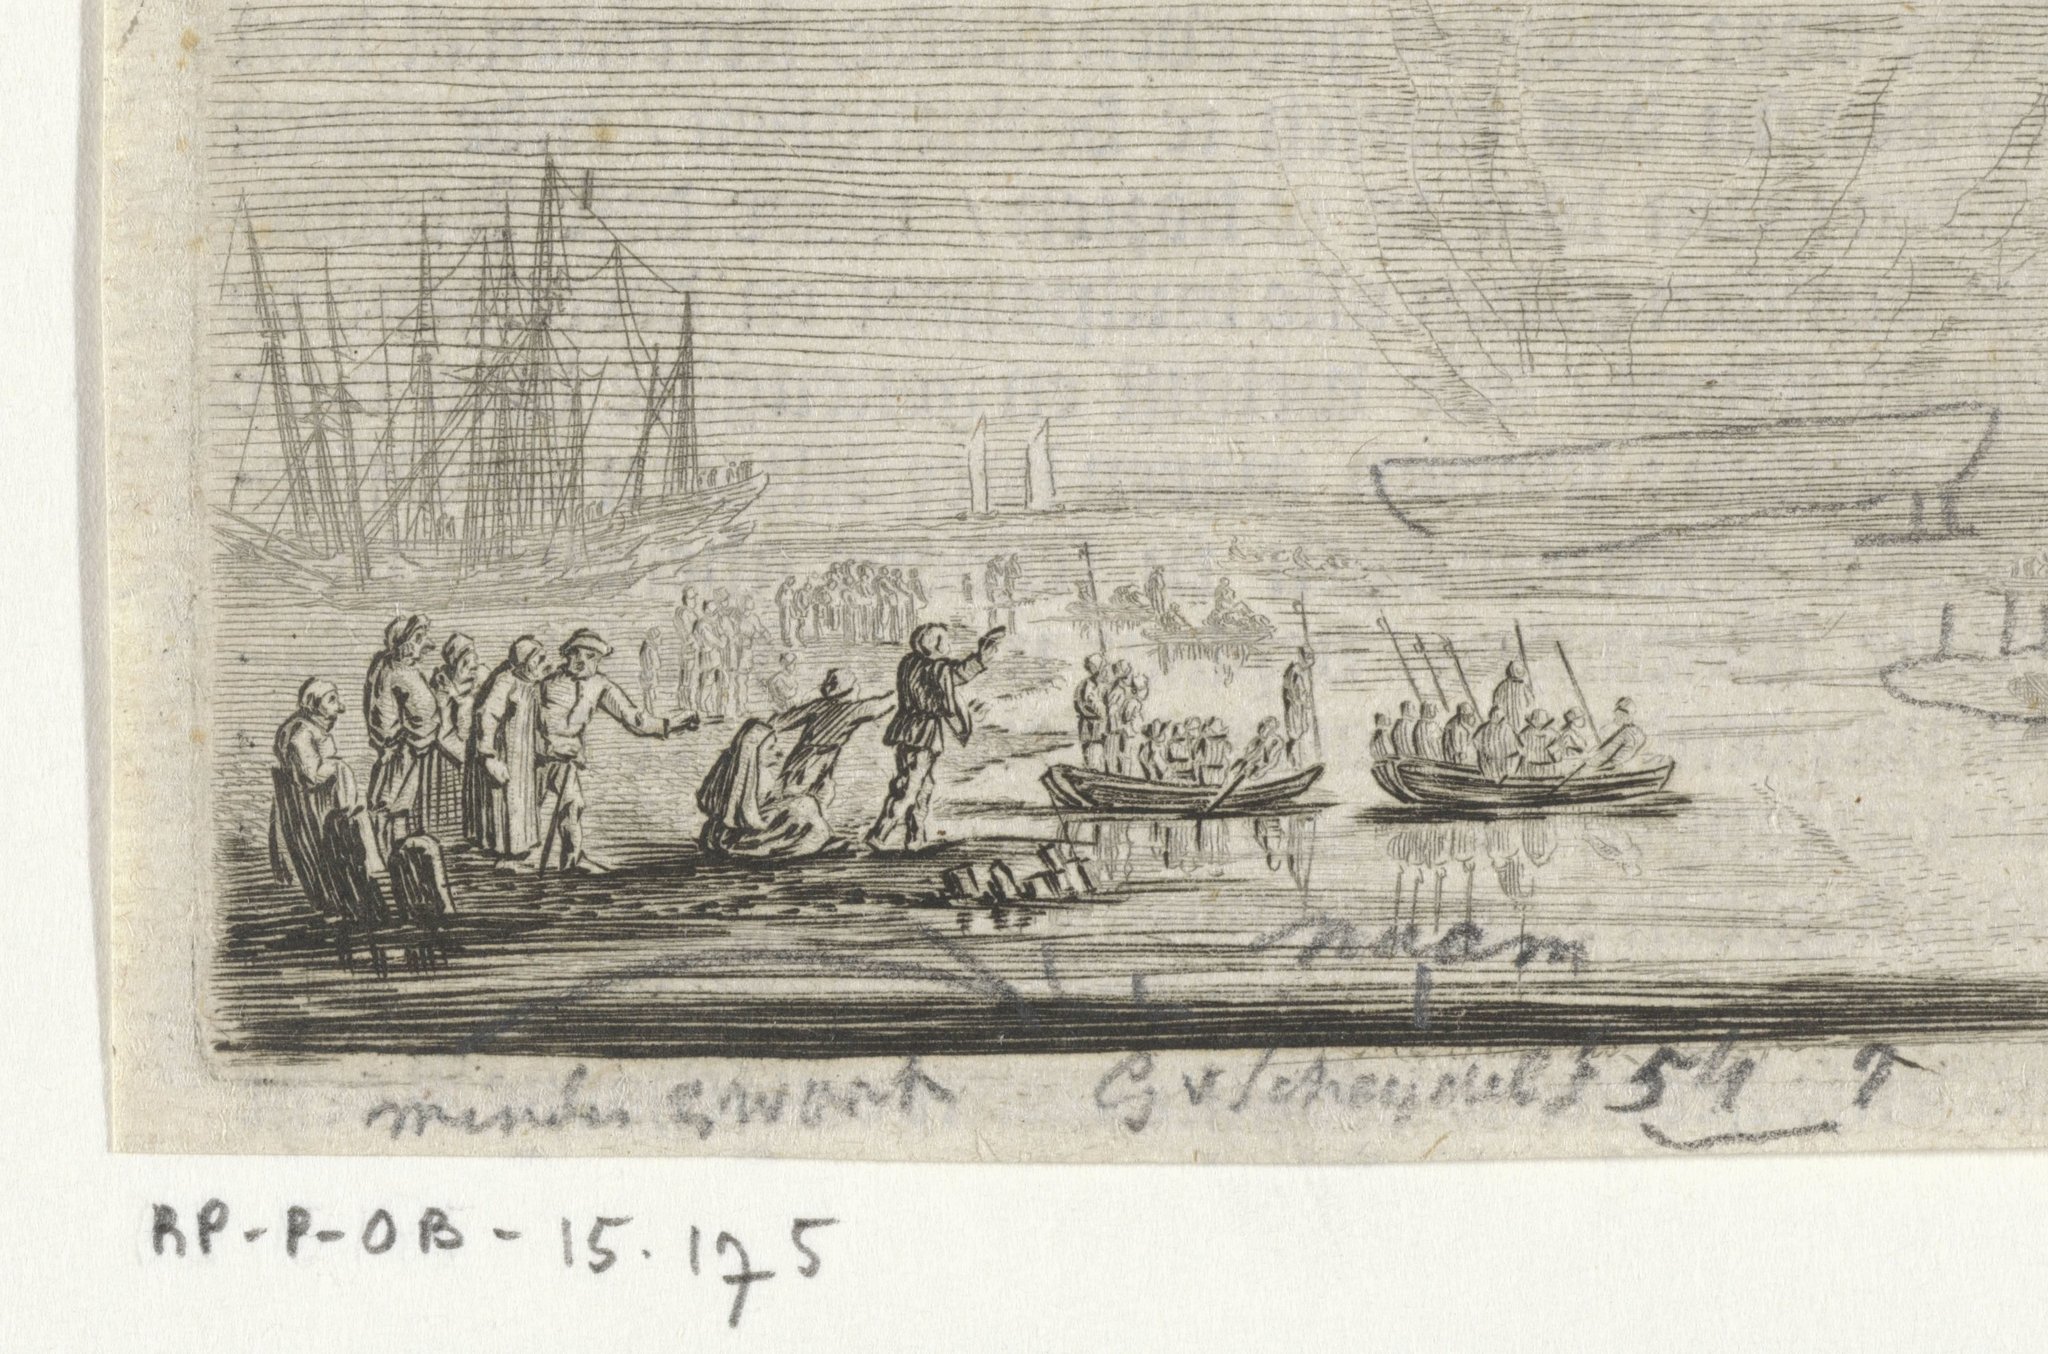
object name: print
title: Brandend schip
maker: Anonymous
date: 1605-1703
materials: paper, pencil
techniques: engraving, etching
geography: netherlands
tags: setting on fire (of conquered city) (+ sailing-ships)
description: Een brandend schip omgeven door verschillende schuitjes. Op een afstandje staan figuren te kijken.